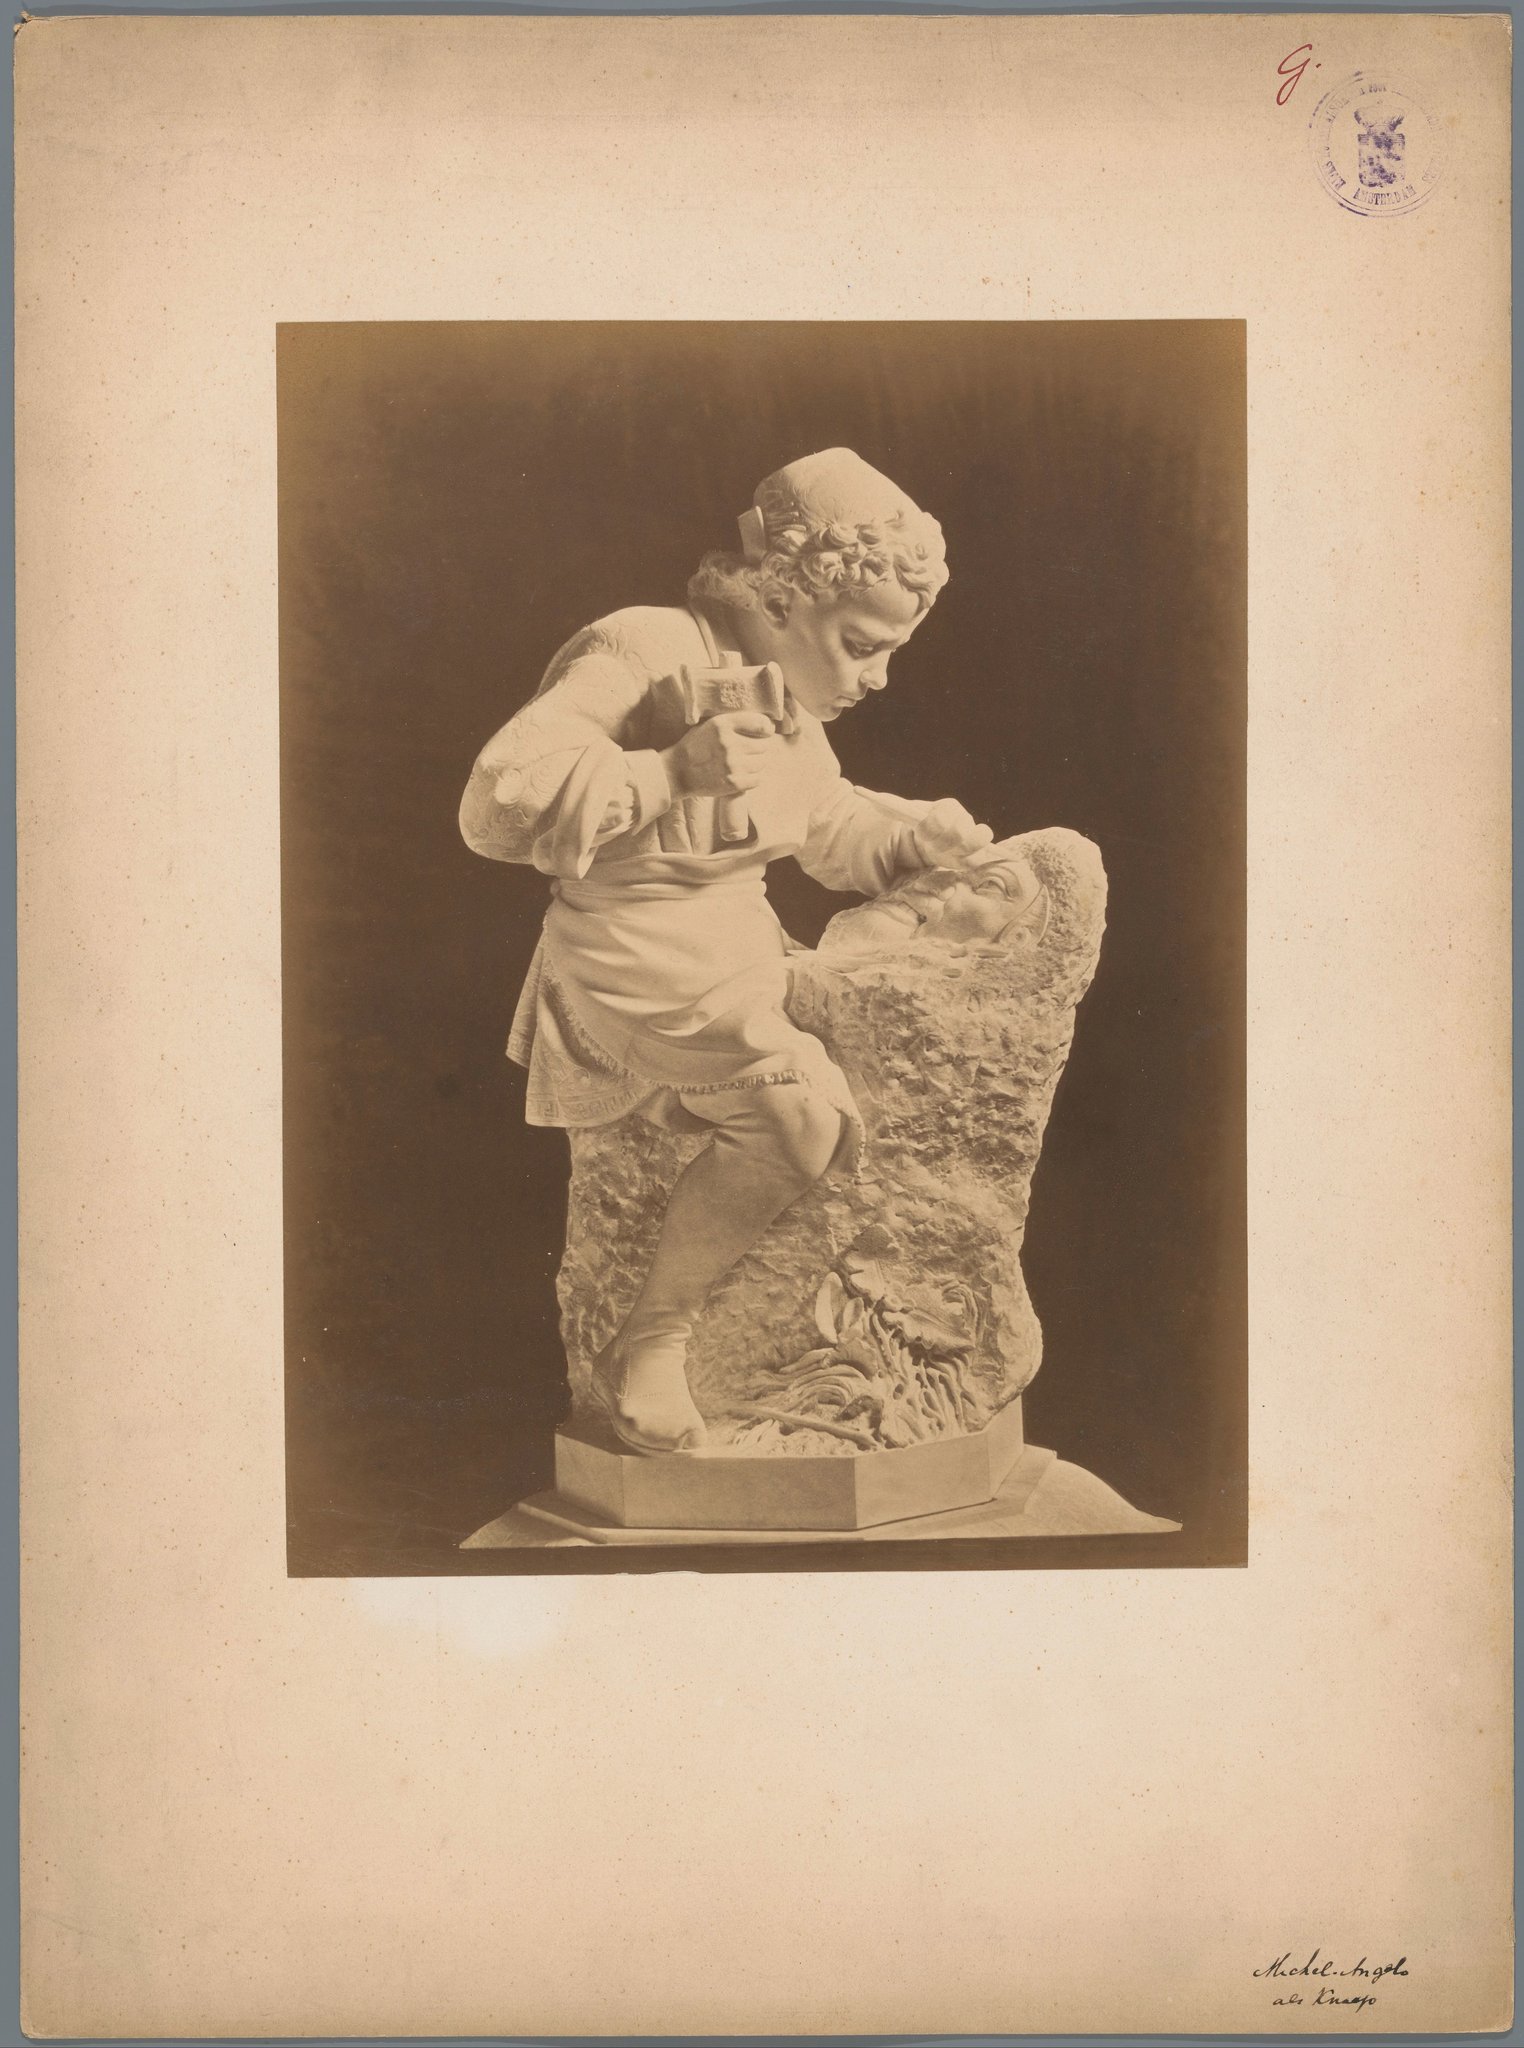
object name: photograph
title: Beeld (of afgietsel van een beeld) van een jongen die beeldhouwt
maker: Anonymous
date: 1850-1900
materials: cardboard, photographic support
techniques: albumen print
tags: sculptor at work, sculpture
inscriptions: inscription: ‘G’, collector's mark: ‘Rijks normaalschool voor teekenonderwijzers Amsterdam’, inscription: ‘MIchael-Angelo/ als Knaap’